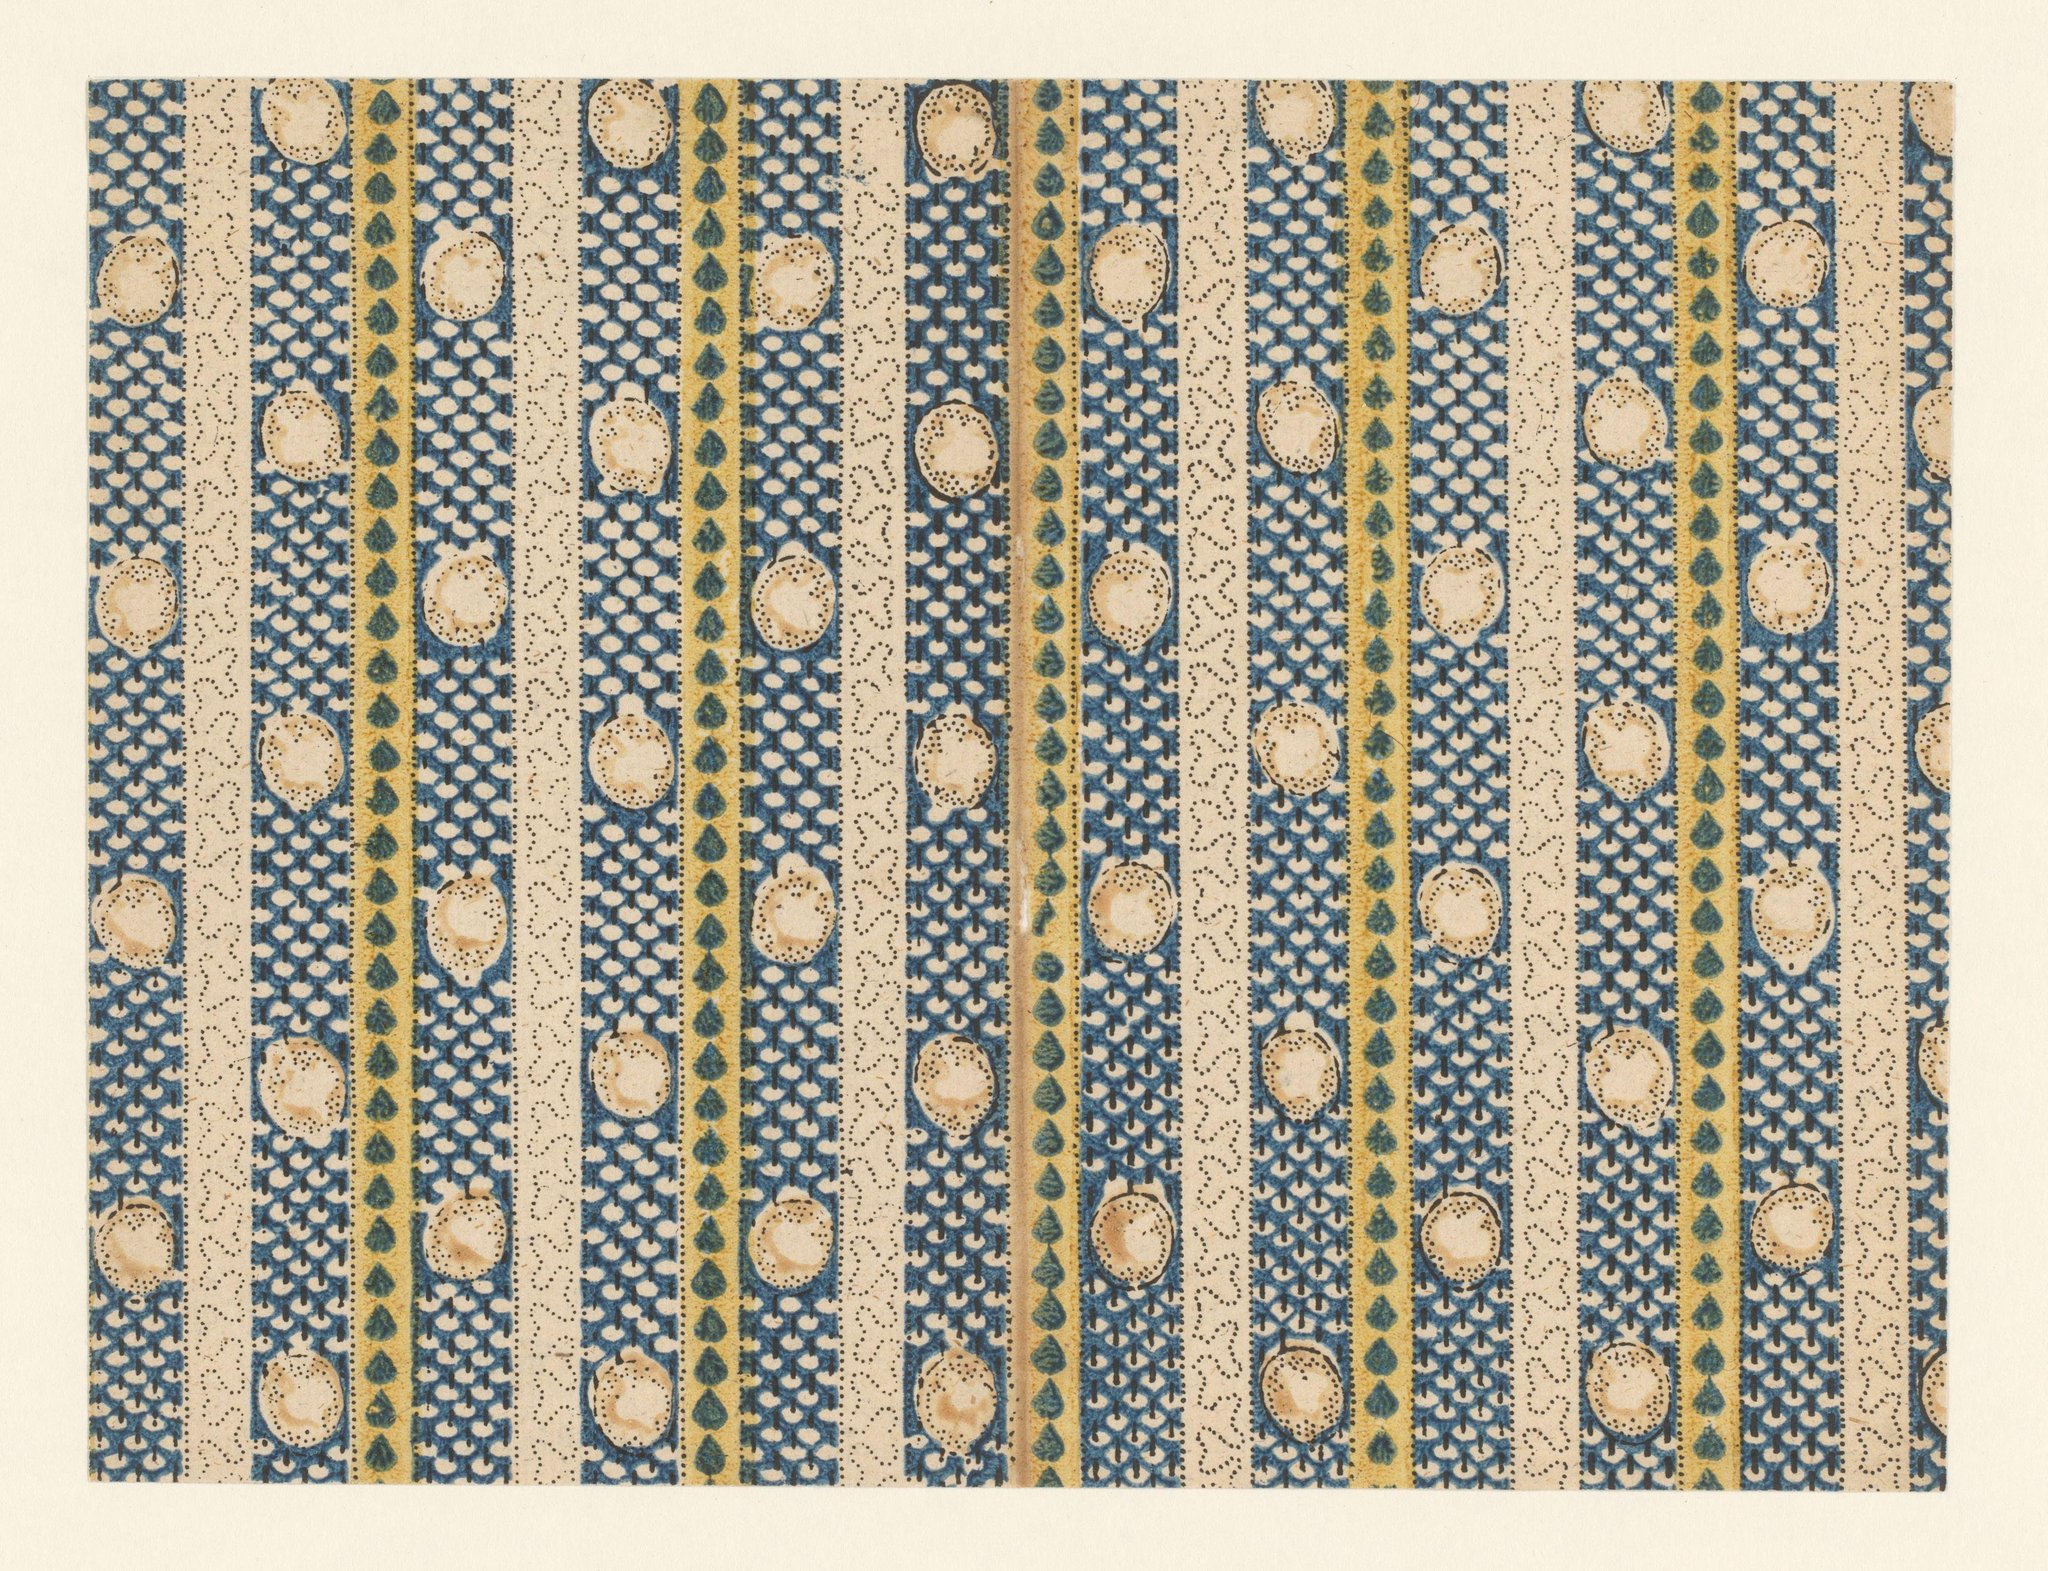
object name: wrapper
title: Blad met banenpatroon met ovaal motief, schubbenpatroon en kronkellijnen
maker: Anonymous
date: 1700-1850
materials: paper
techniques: printing block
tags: fantasy ornament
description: Blad met verticaal banenpatroon met ovaal motief in schubbenpatroon en kronkellijnen van punten. Gebruikt als omslag.